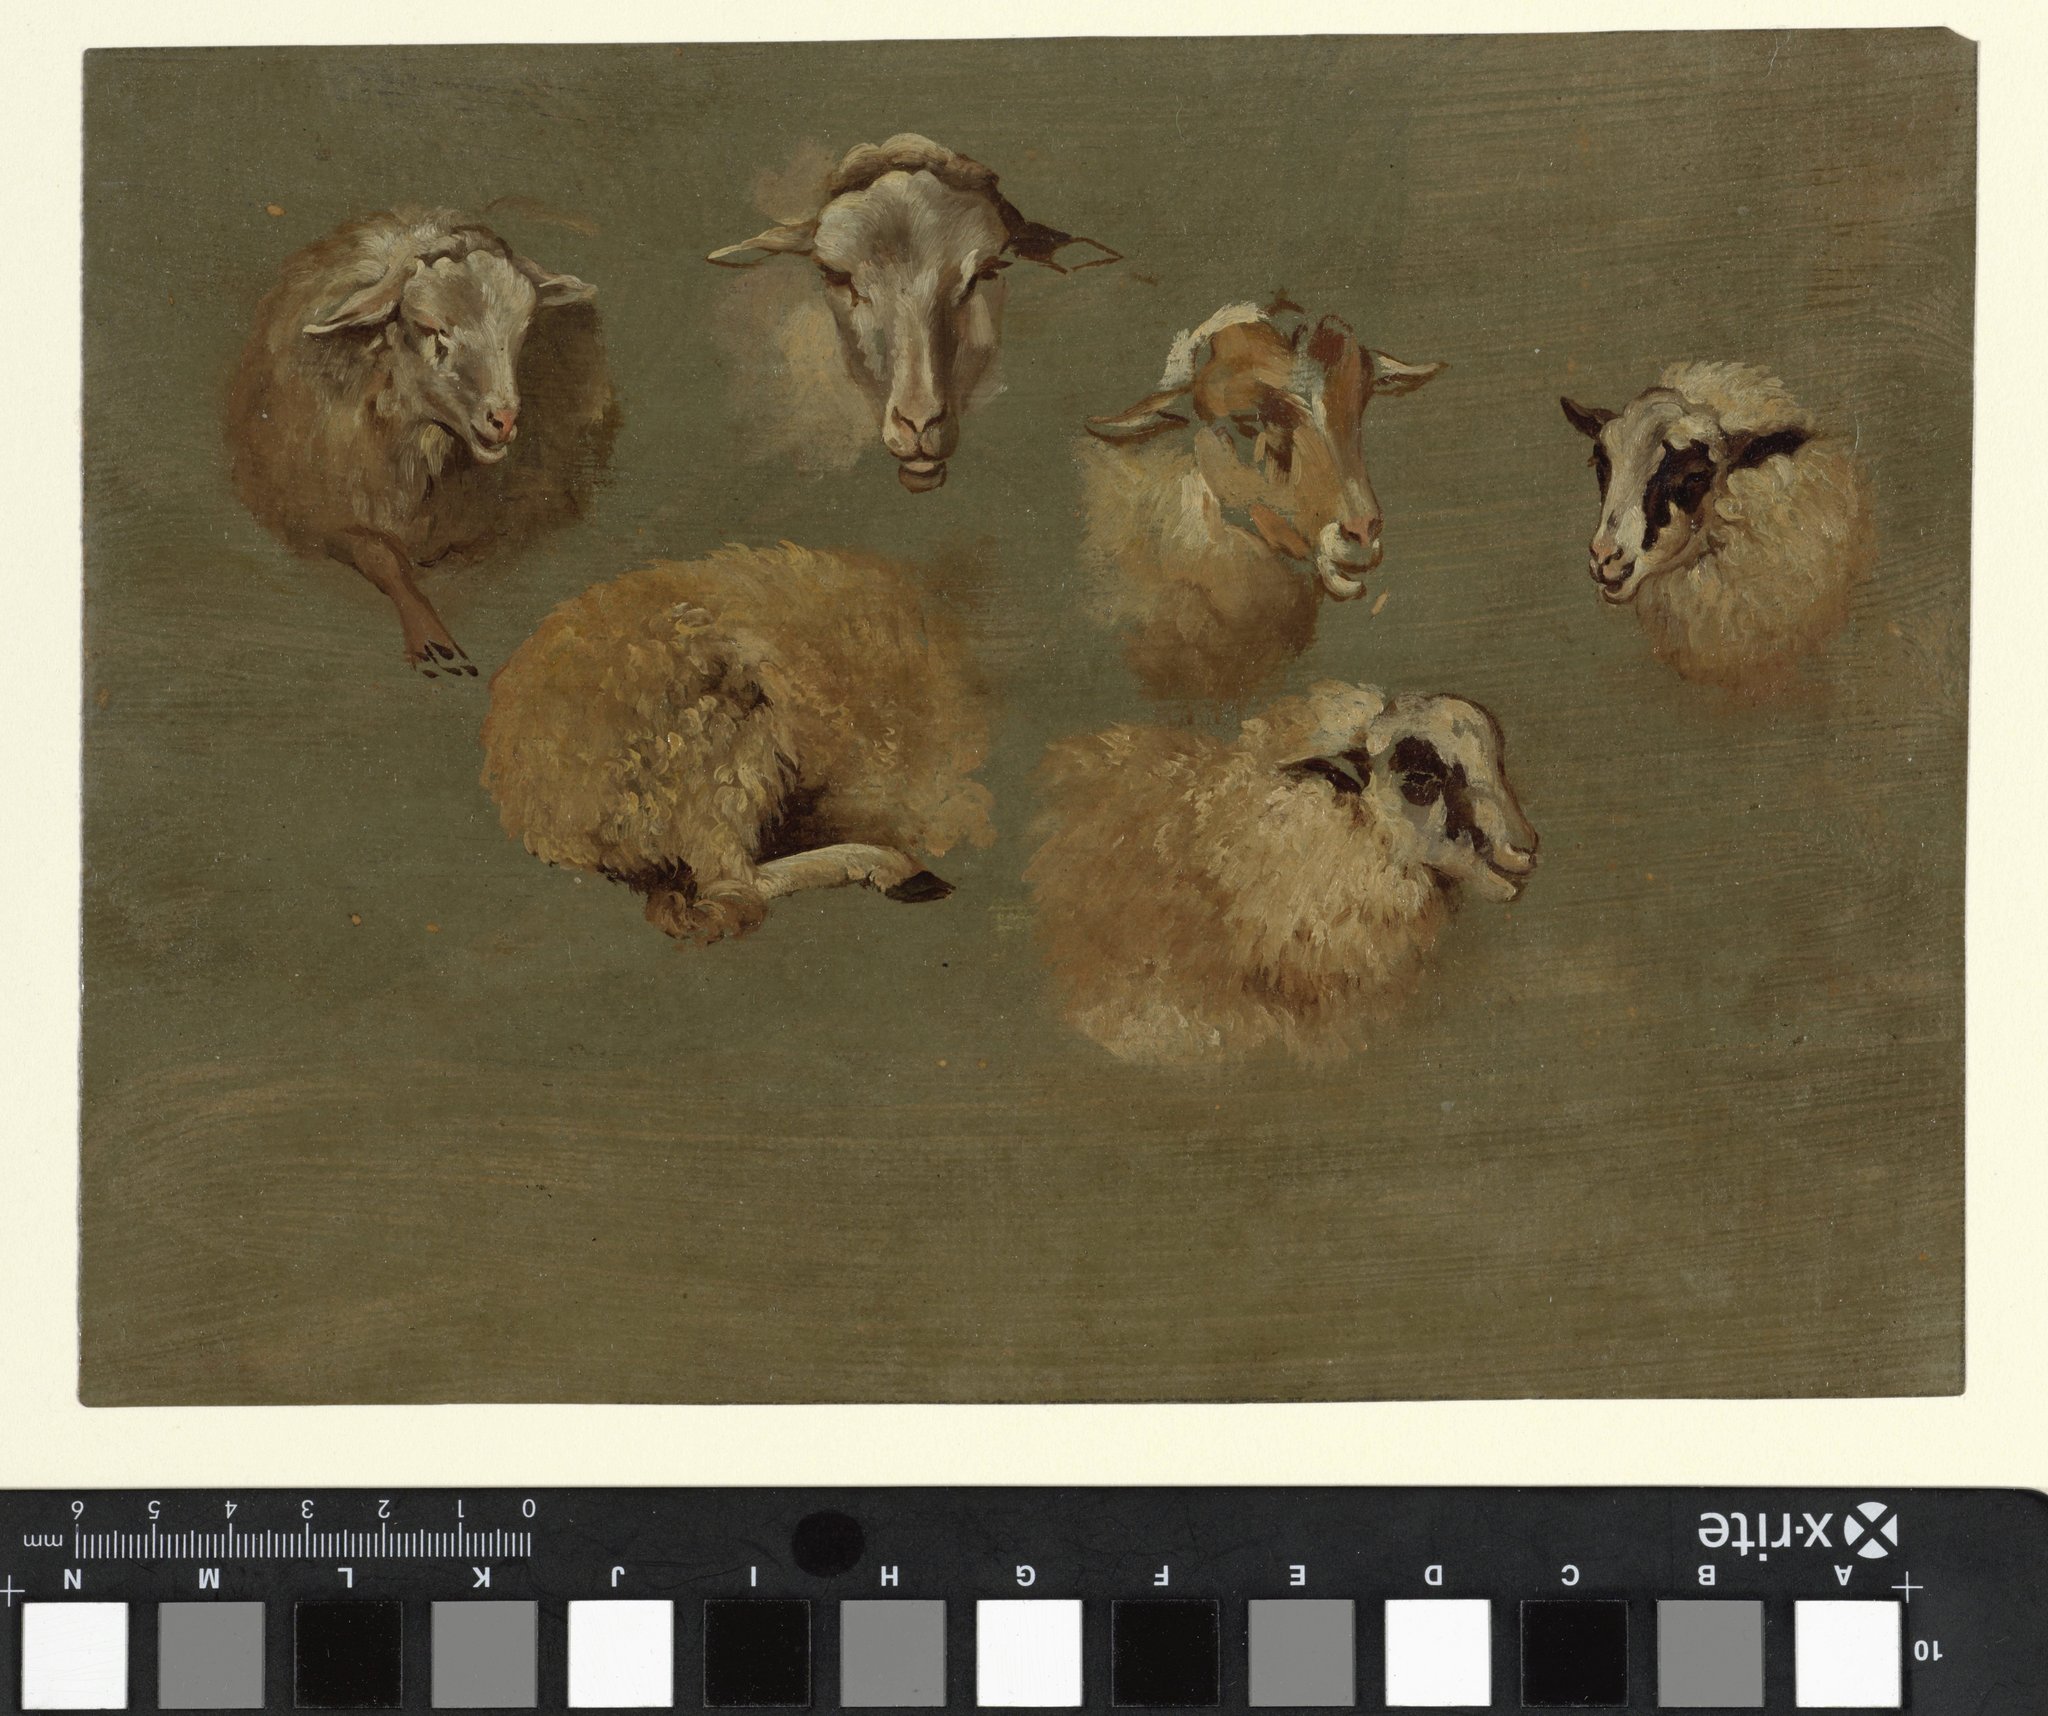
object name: drawing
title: Studieblad met schapen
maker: pieter jan guise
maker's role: draughtsman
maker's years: 1814-1859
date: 1824-1859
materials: oil, paper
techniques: brush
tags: sheep